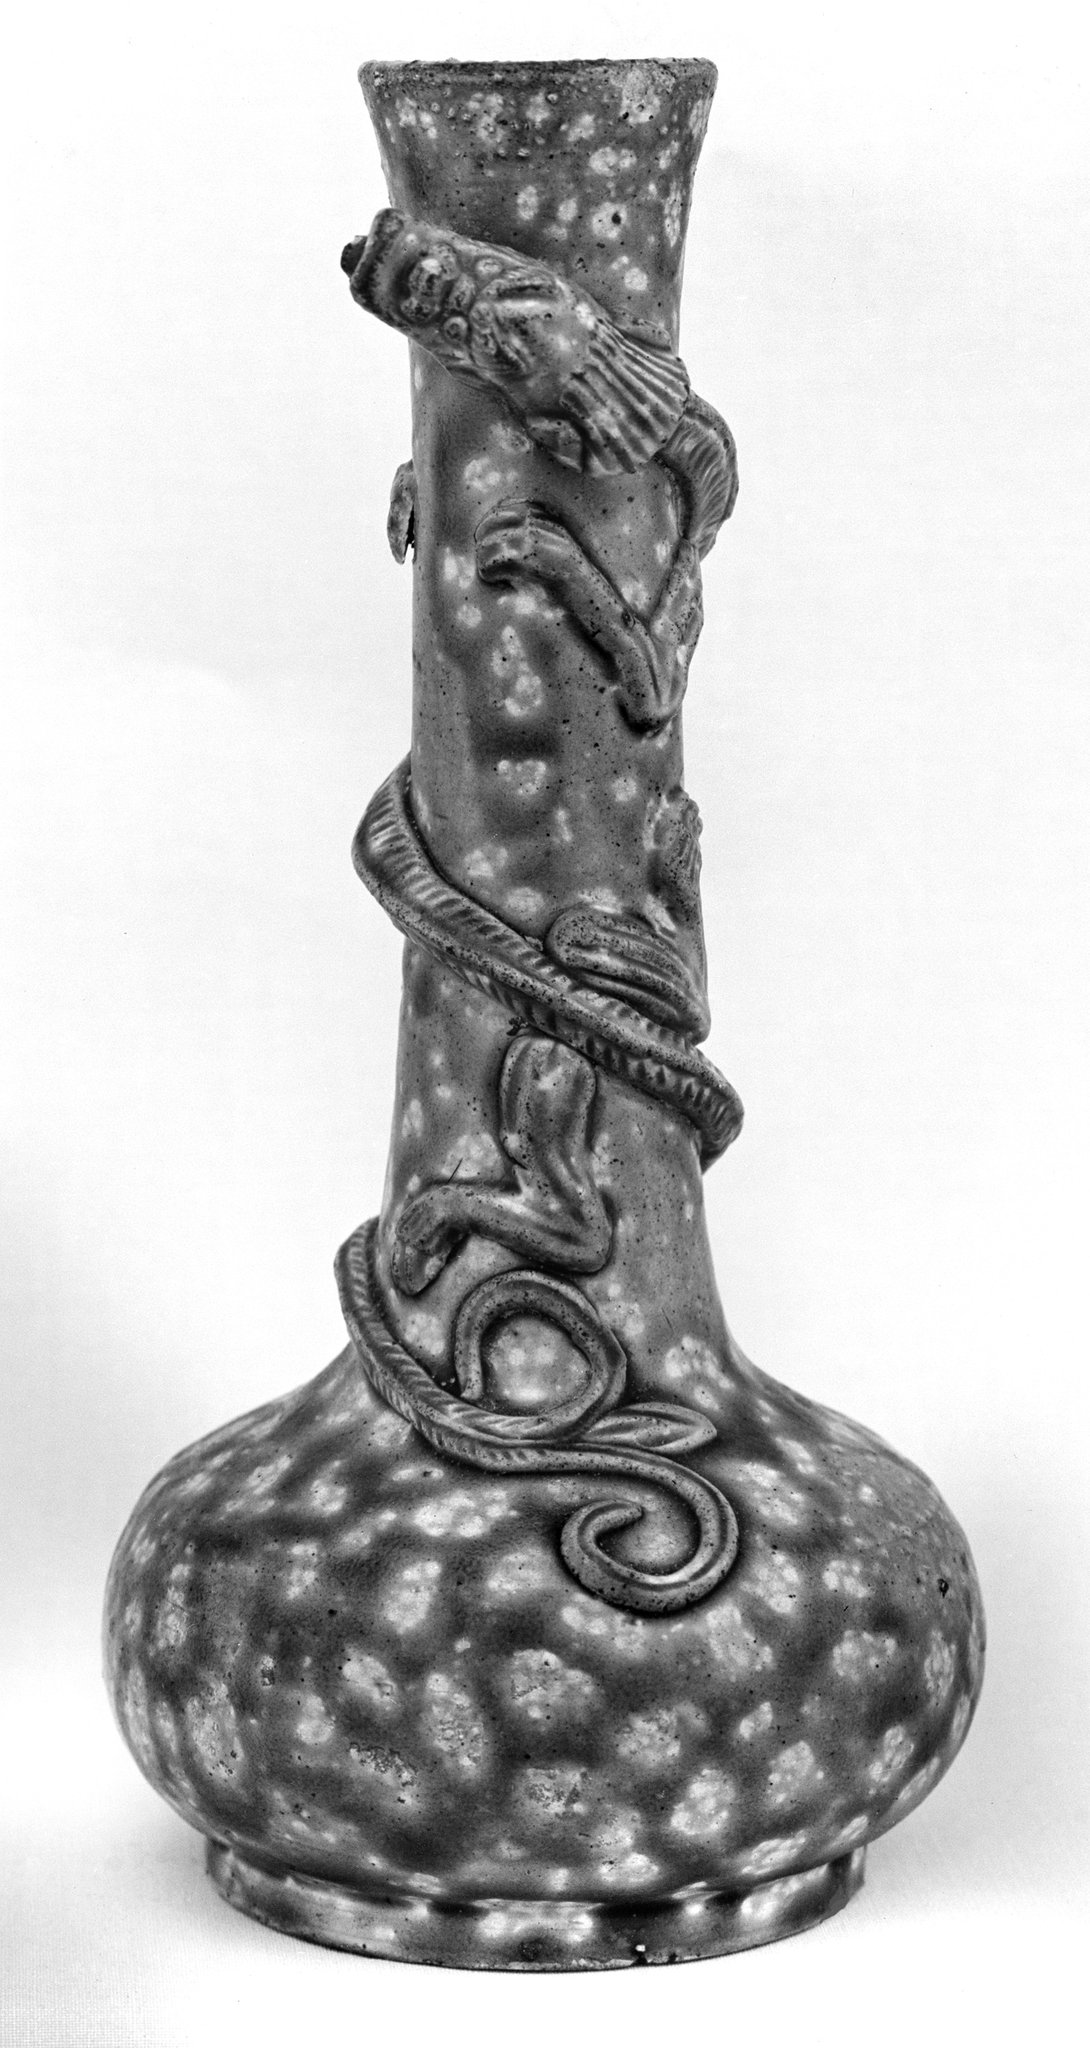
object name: bottle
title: Bottle with an entwined dragon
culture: chinese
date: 1501-1700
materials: ceramic glaze, glaze, stoneware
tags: dragons